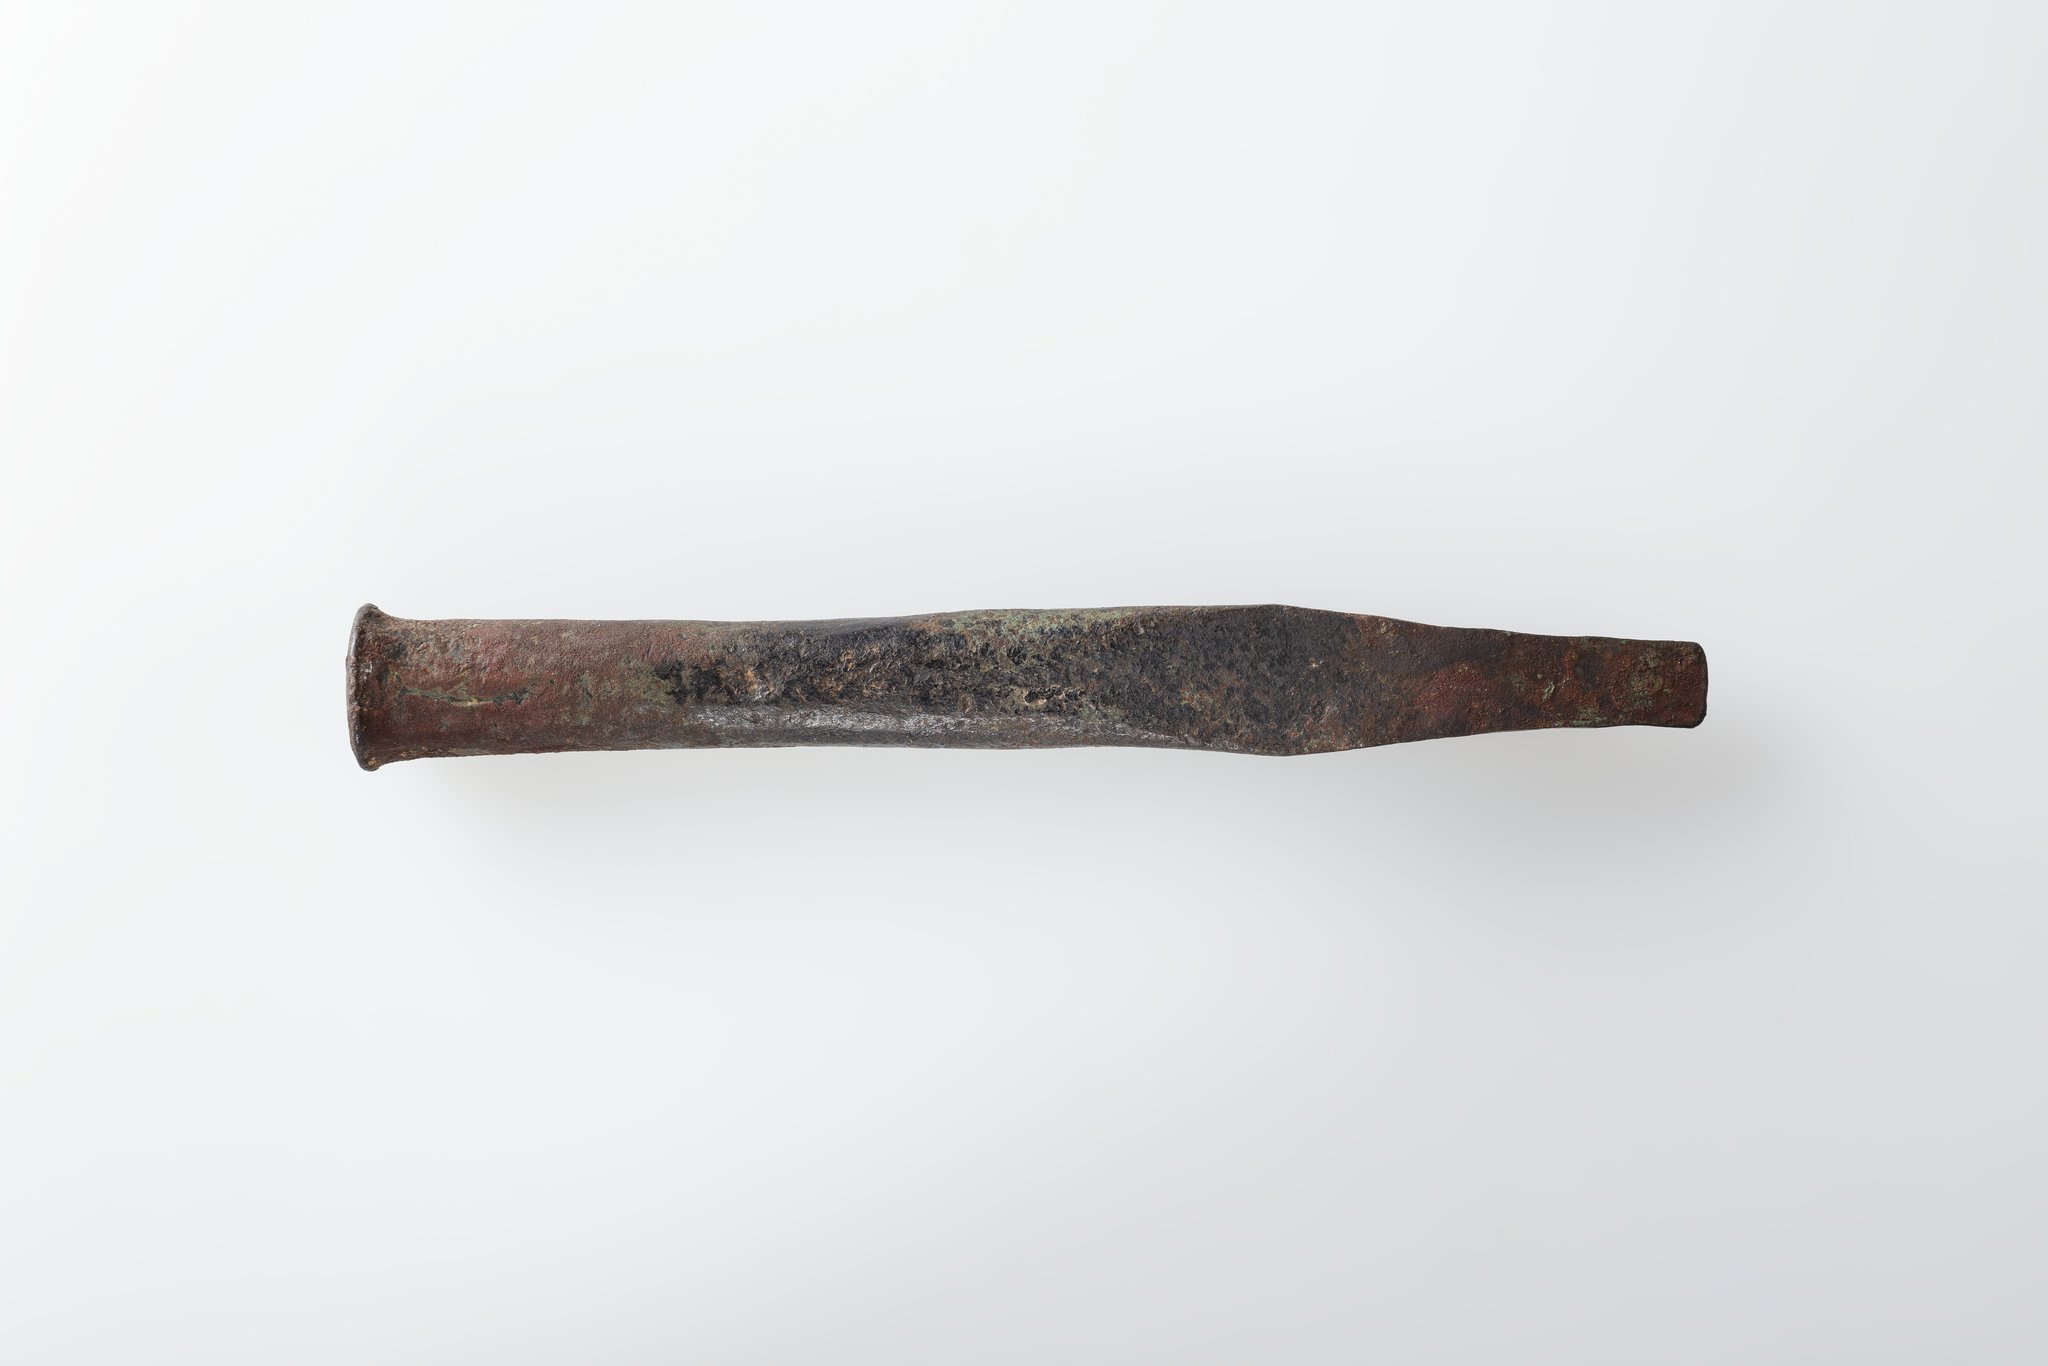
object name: chisel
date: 1200 BCE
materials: bronze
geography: egypt